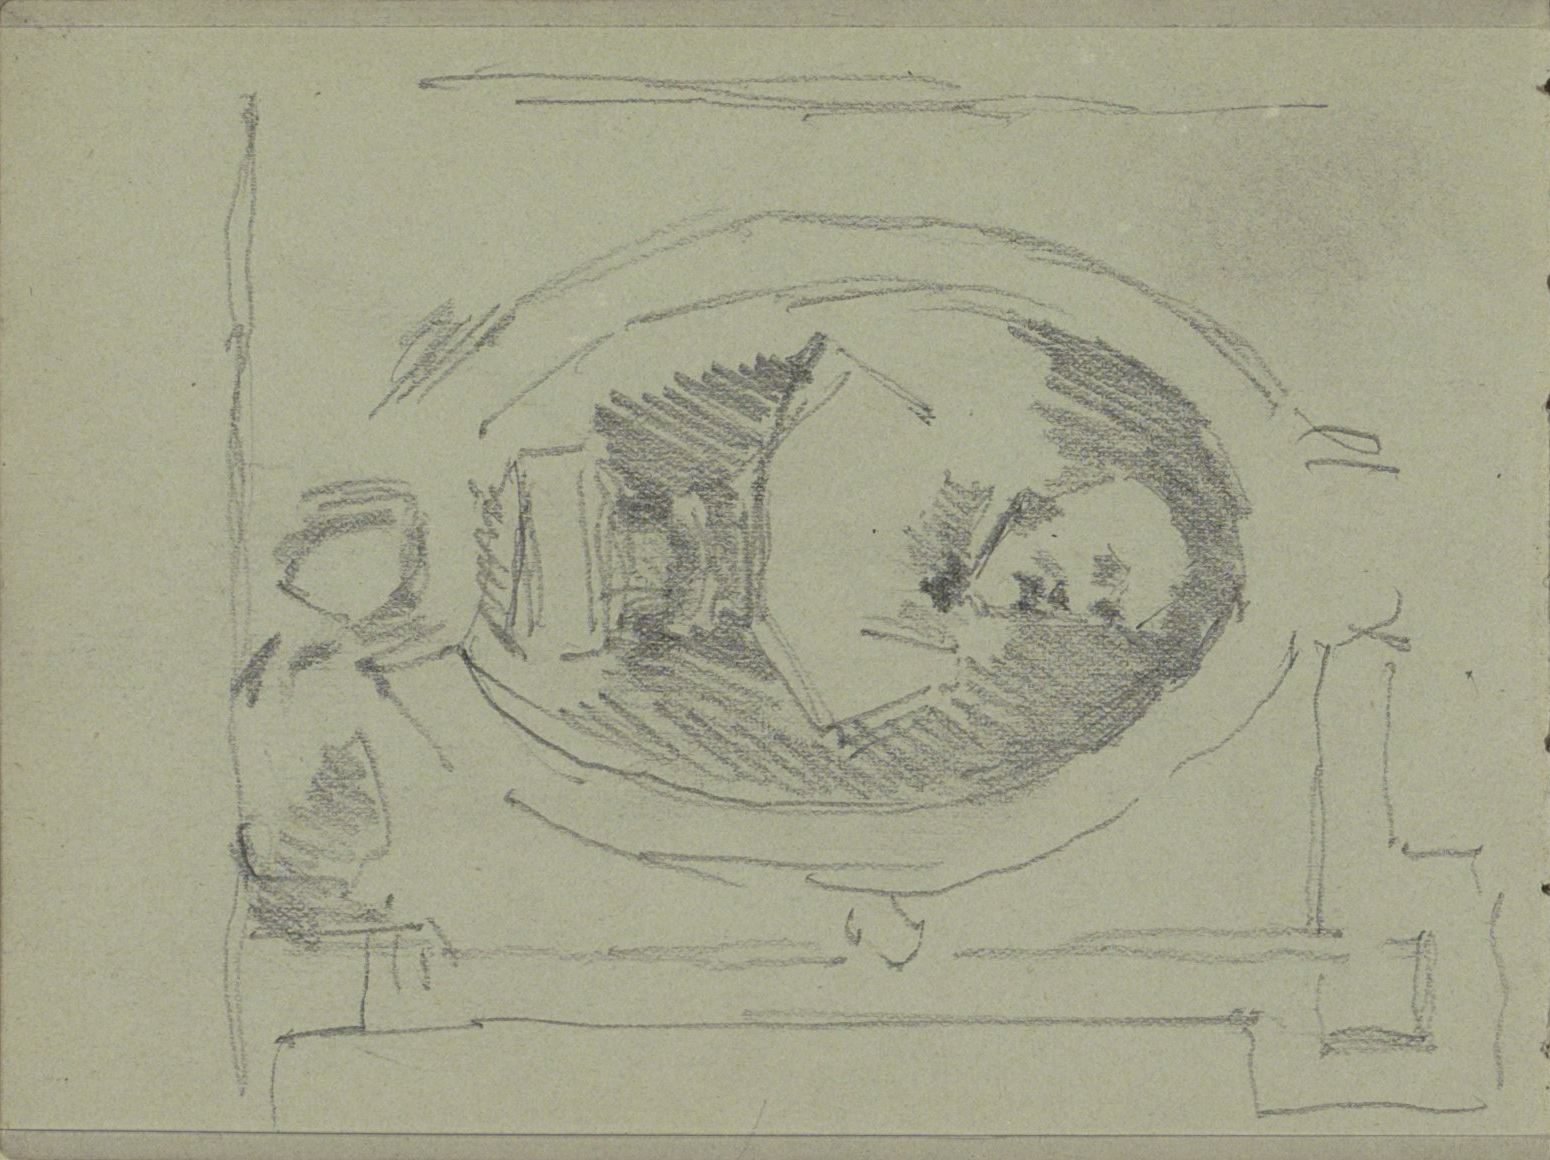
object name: sketchbook leaf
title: Portretbuste van een man, in een ovaal op een sokkel in een nis geplaatst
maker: george clausen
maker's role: draughtsman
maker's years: 1852-1912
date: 1874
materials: paper, pencil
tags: parts of church interior: niche, sculpture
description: Blad 12 verso uit een schetsboek met 37 bladen.